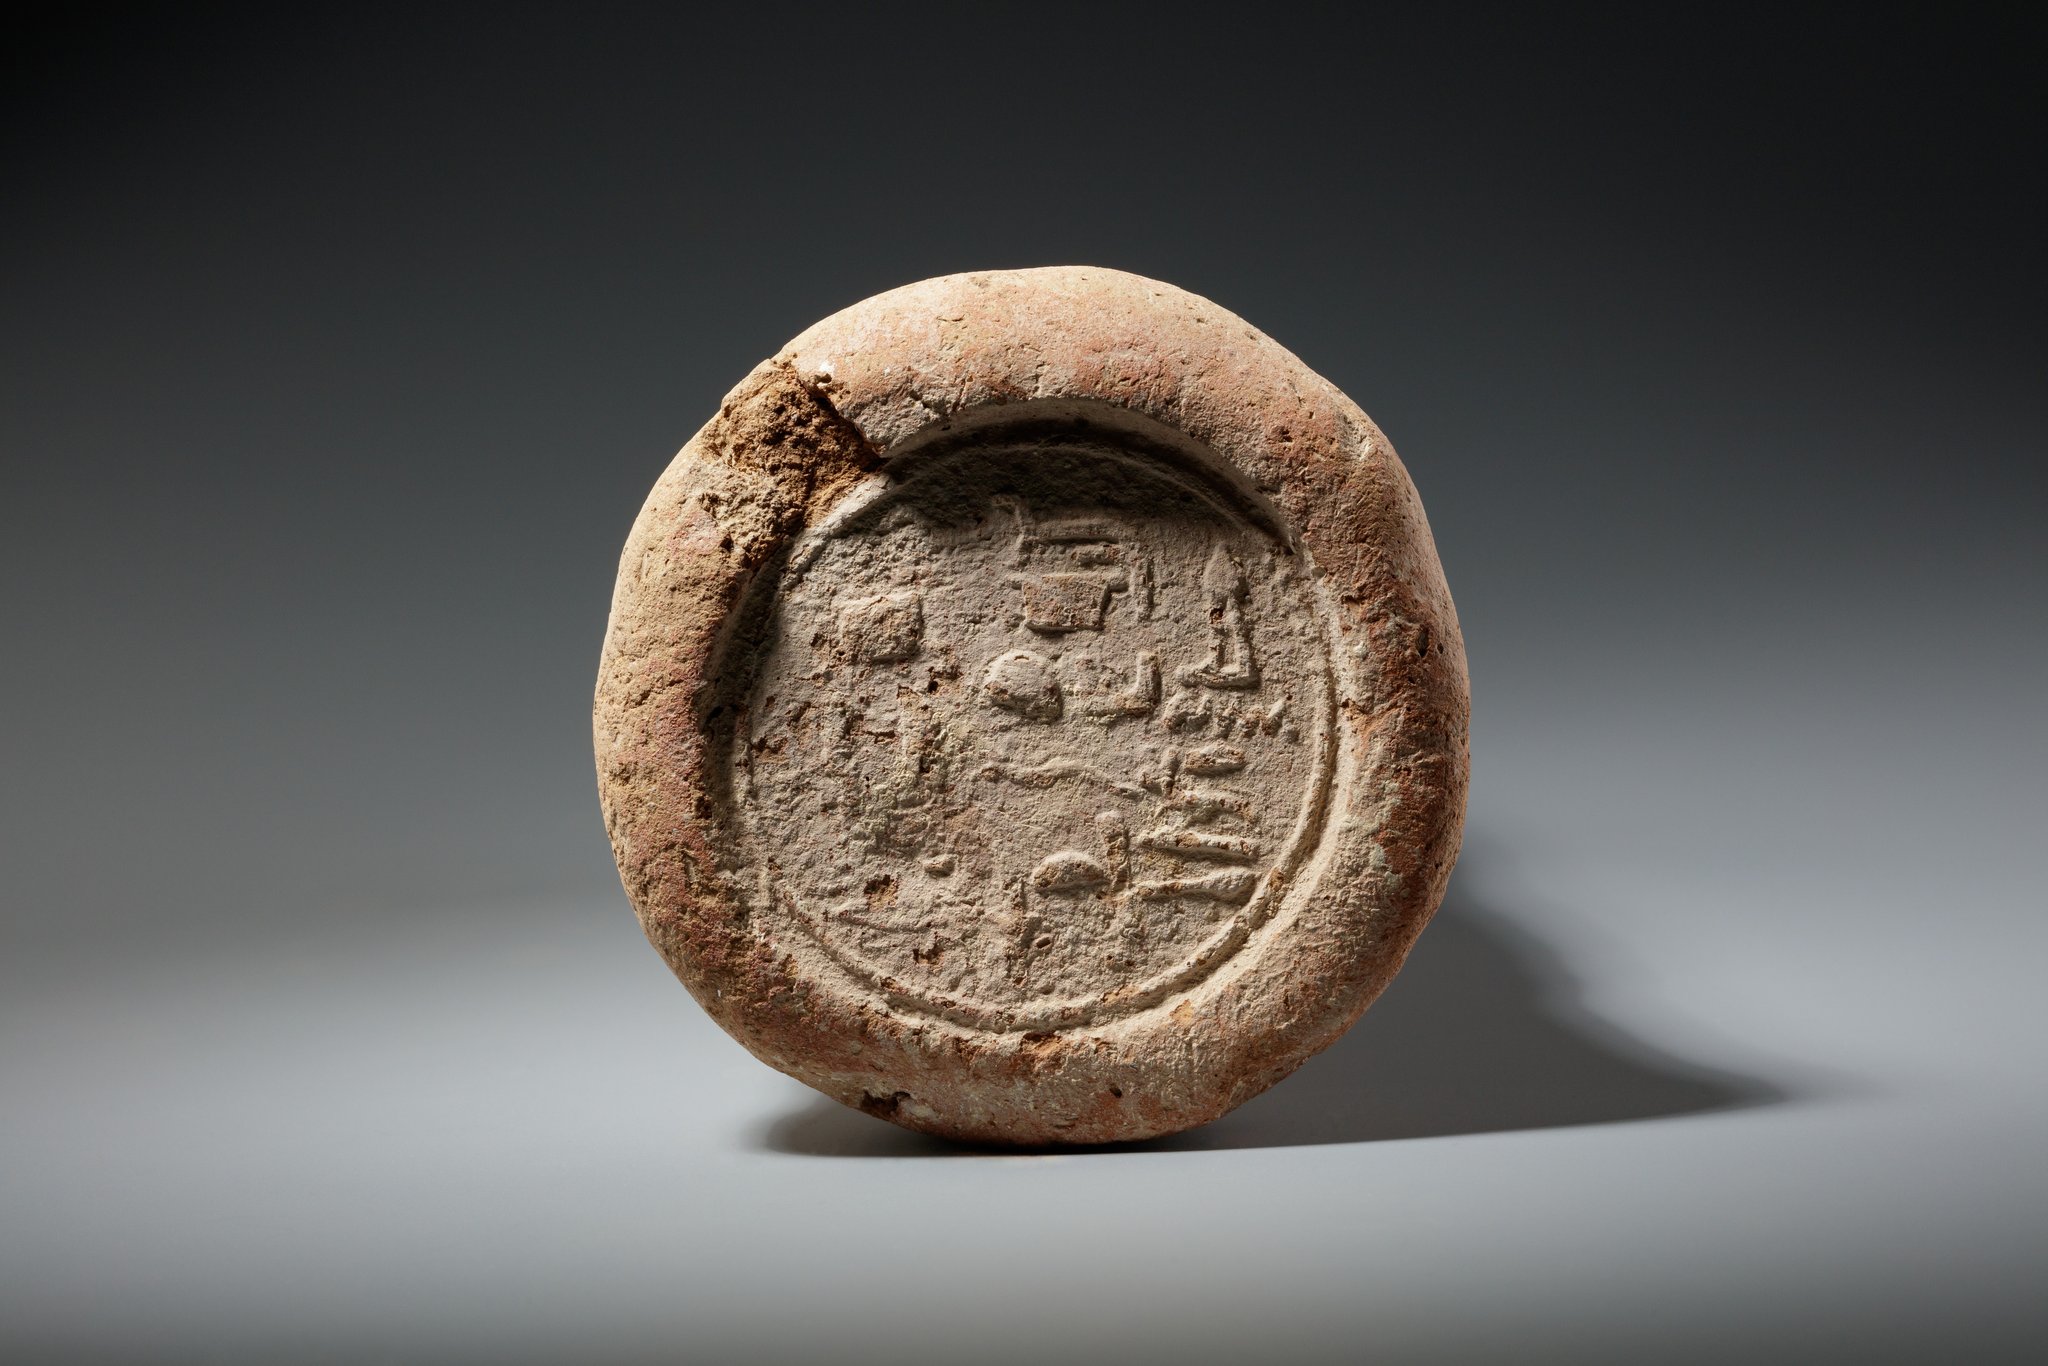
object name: cone, davy 139, intef, tt 155, royal herald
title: Funerary Cone of the Royal Herald Intef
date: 1479-1453 BCE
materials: pottery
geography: egypt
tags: hieroglyphs